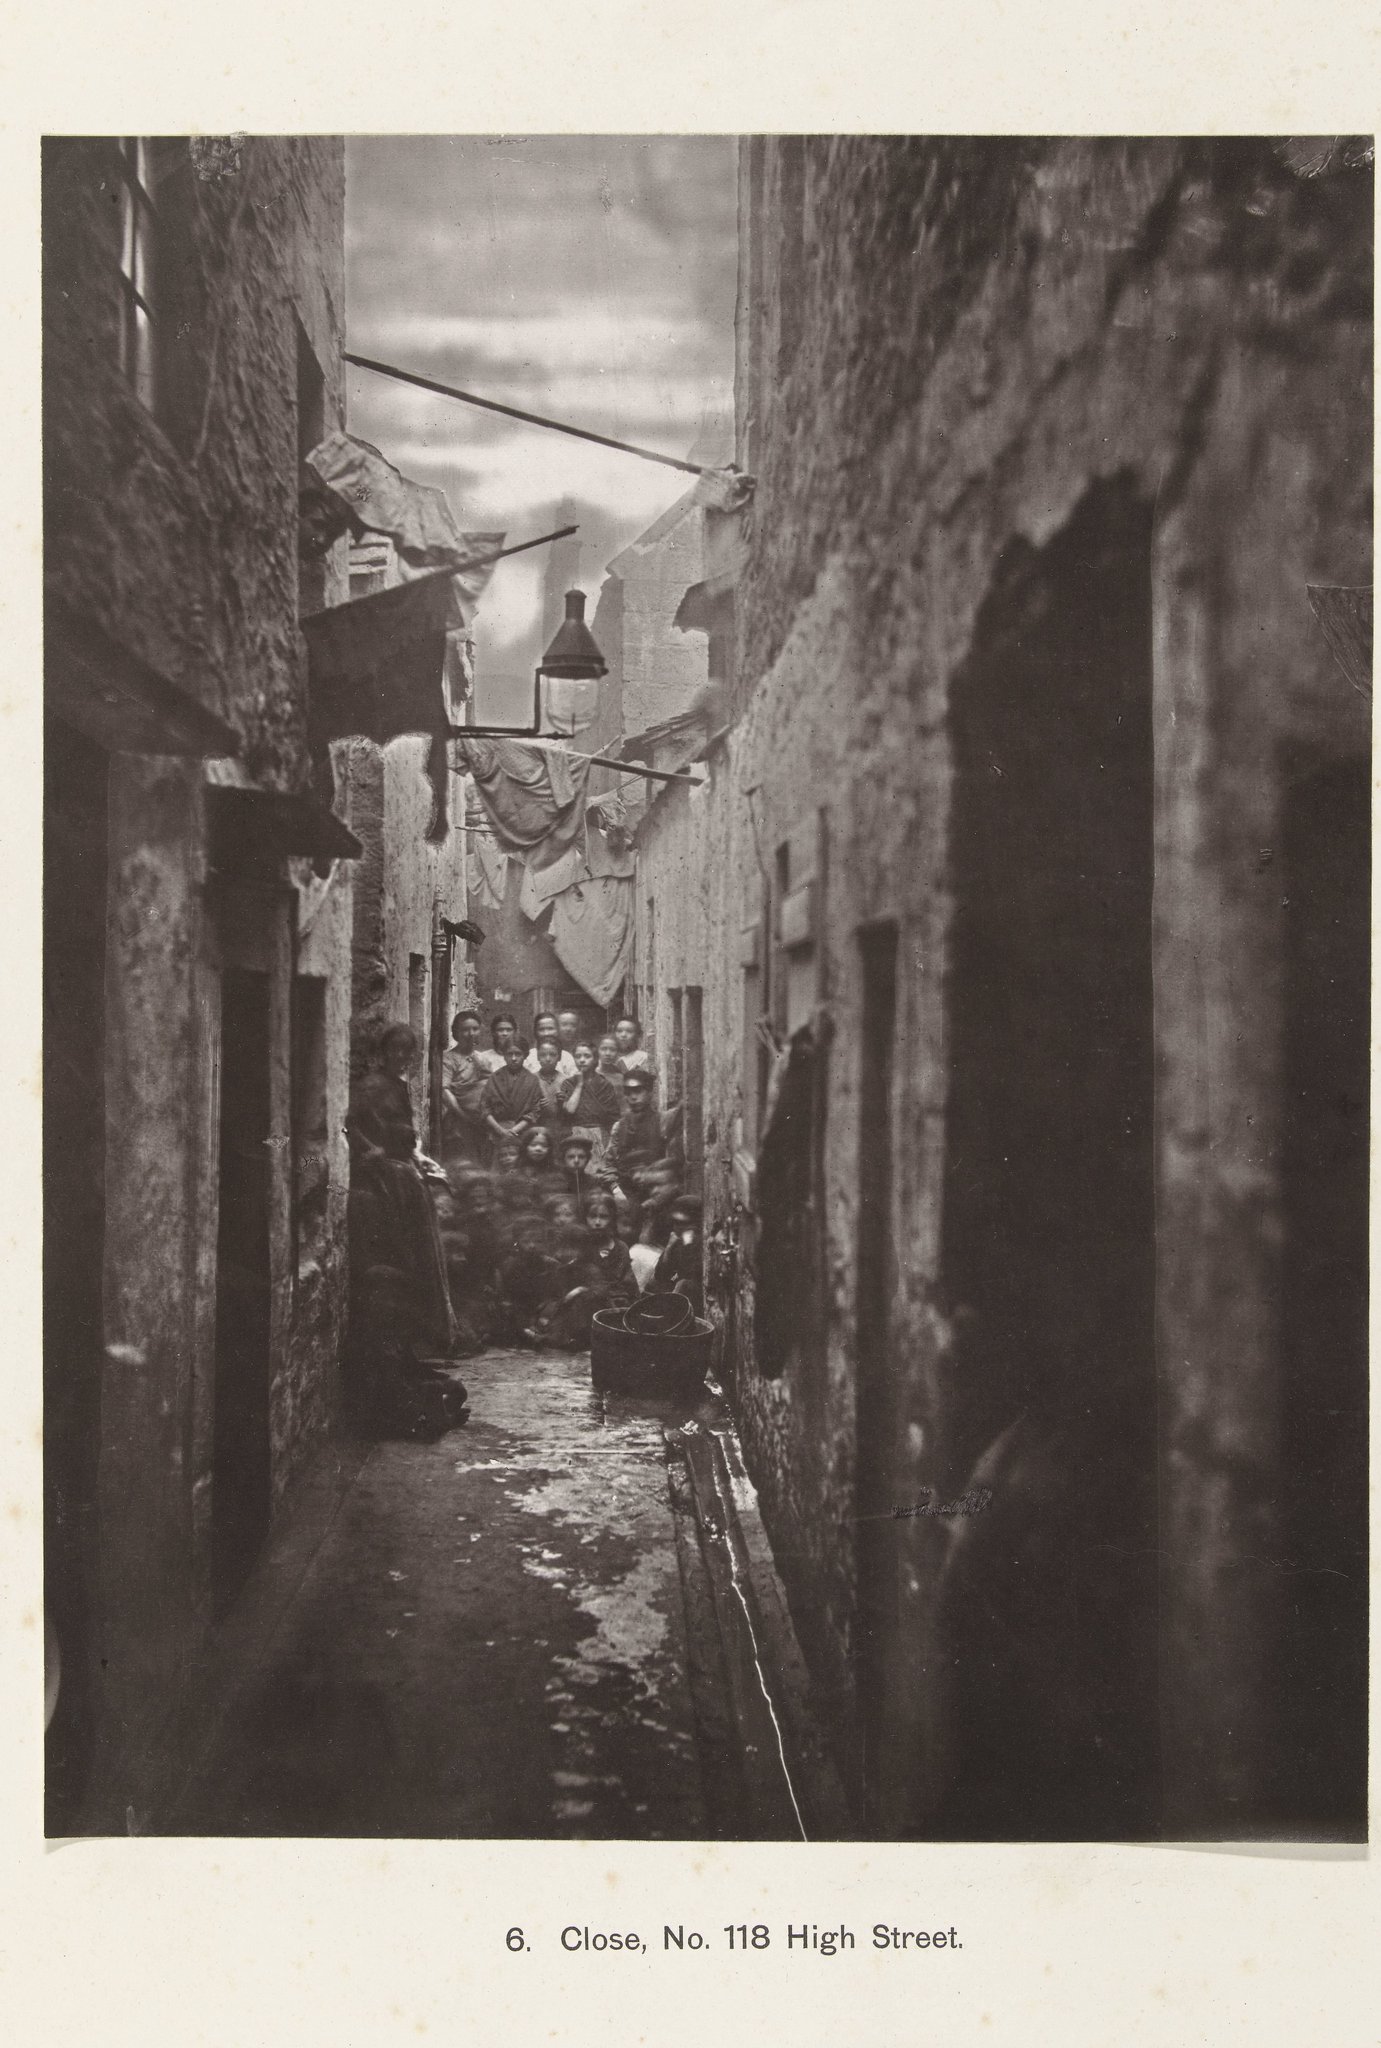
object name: photograph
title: The Slums of Glasgow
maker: thomas annan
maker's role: fotograaf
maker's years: 1829-1887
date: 1868-1877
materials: cardboard, paper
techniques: carbon print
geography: glasgow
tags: lane, alley, anonymous historical persons portrayed in a group, in a group-portrait, glasgow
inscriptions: number: ‘6.’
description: In 1866 Annan purchased for Scotland the patent rights to Joseph Swan’s permanent carbon process to improve the photographic art reproductions he specialized in. As it turned out, his fame rests on the series of slums and alleys of Glasgow that he documented on commission from the Glasgow City Improvement Trust as of 1868. In 1877 he printed 60 sets (of the series of 40 photographs) as carbon prints.